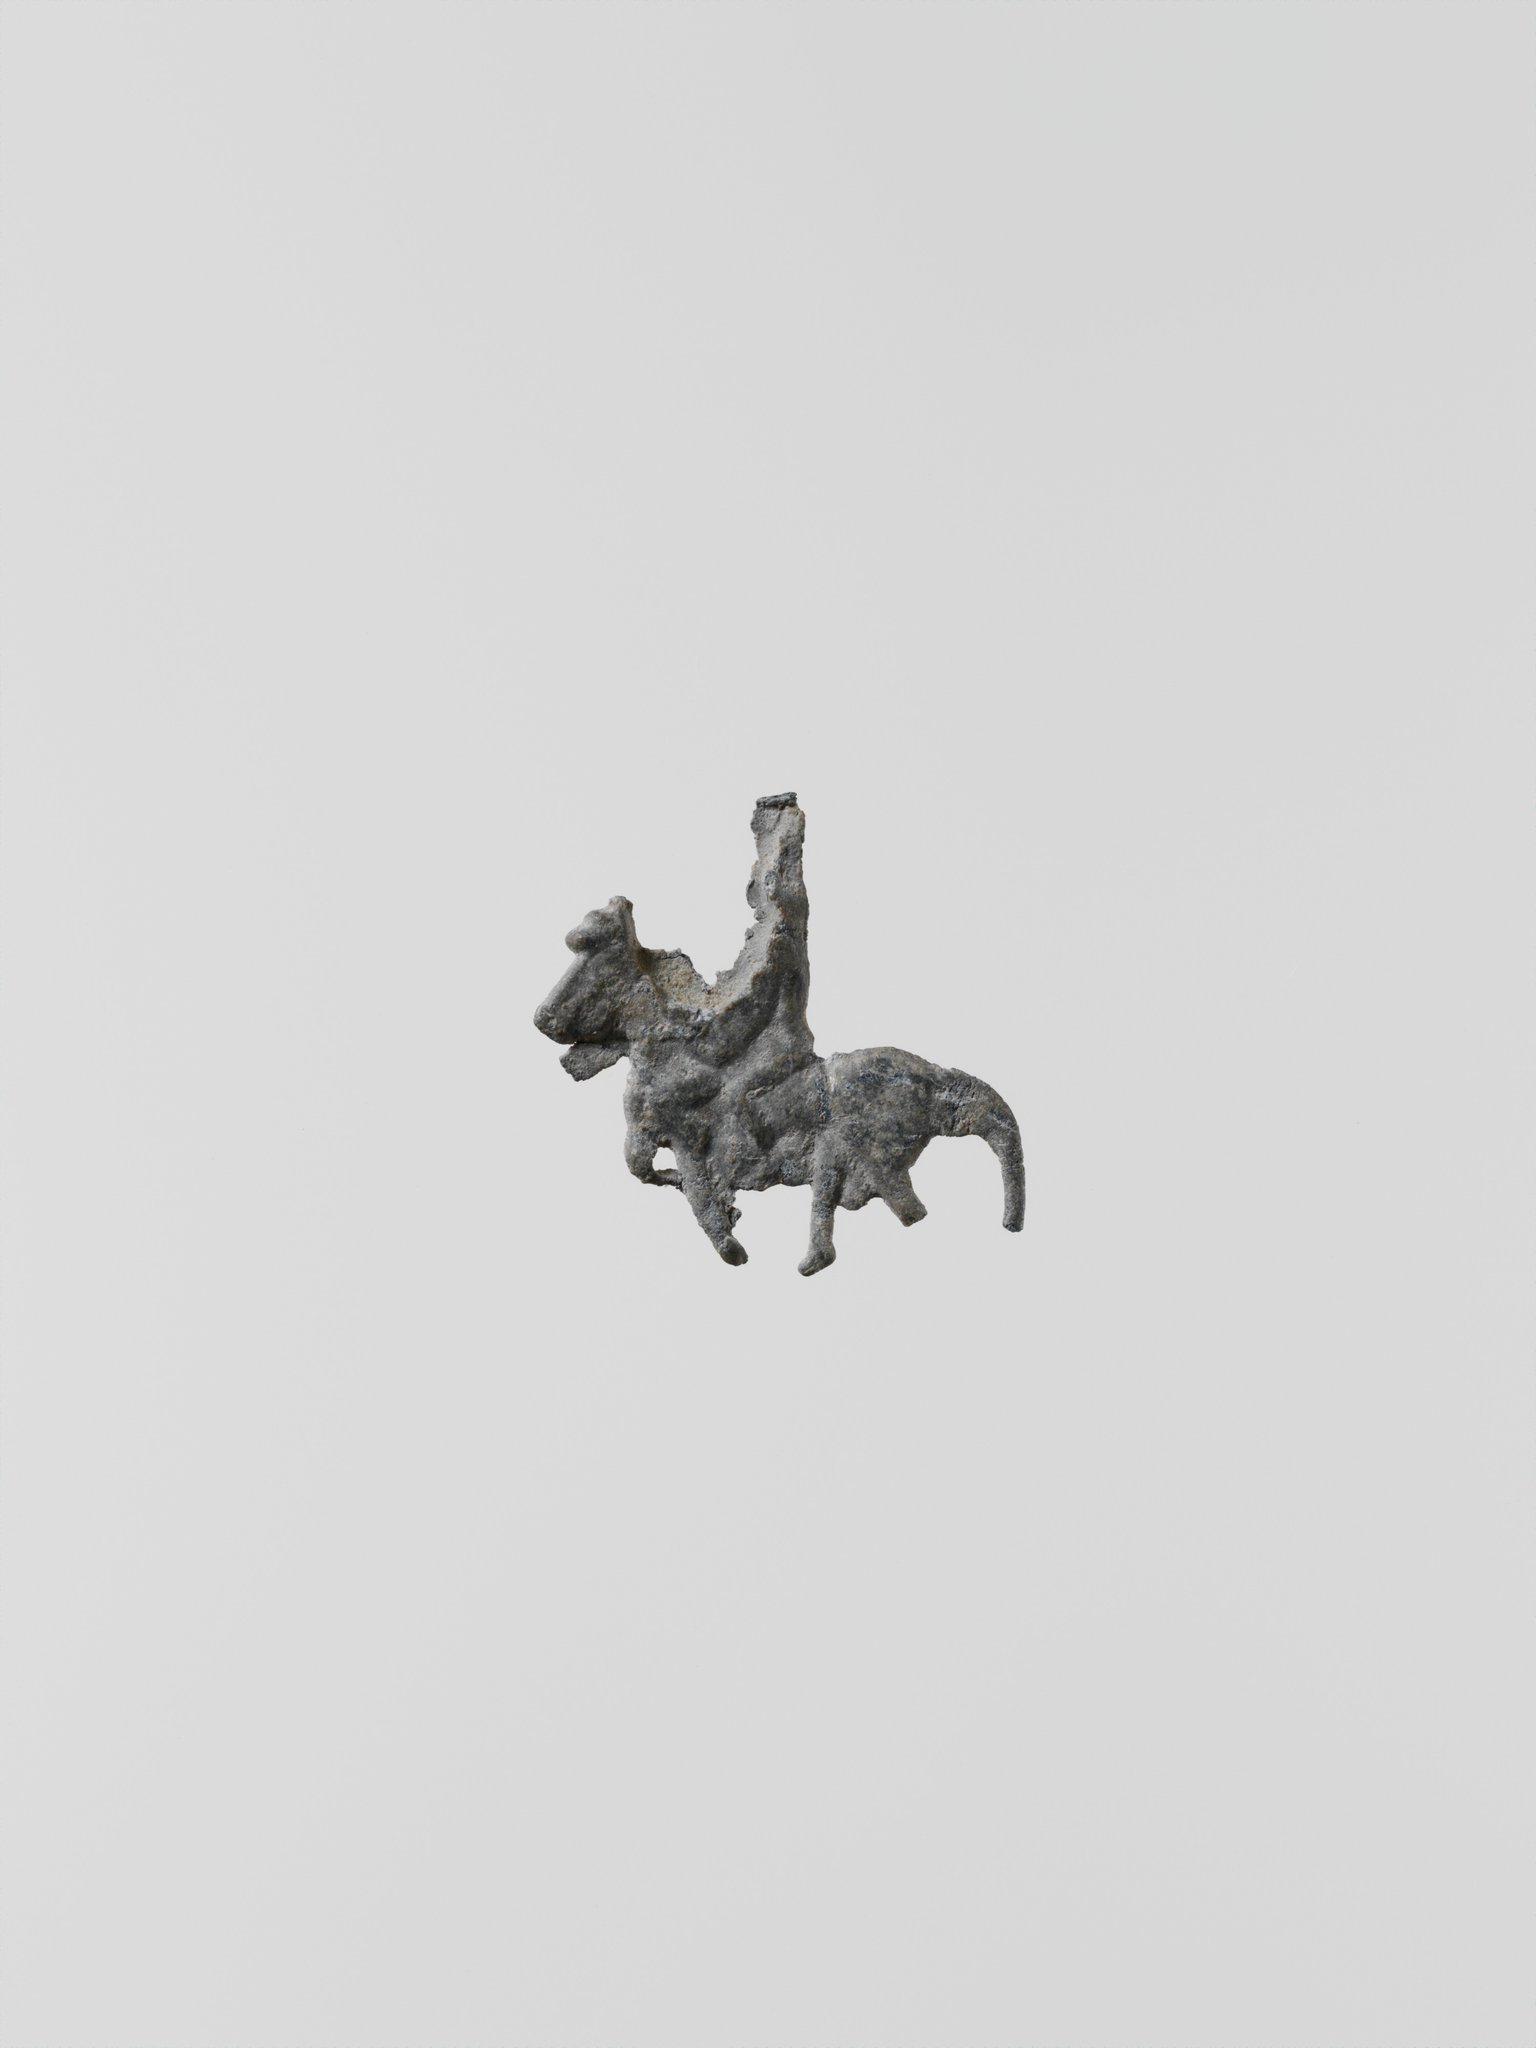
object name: statuette of a horse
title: Statuette of a horseman, 3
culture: greek, laconian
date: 700-501 BCE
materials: lead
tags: men,horses